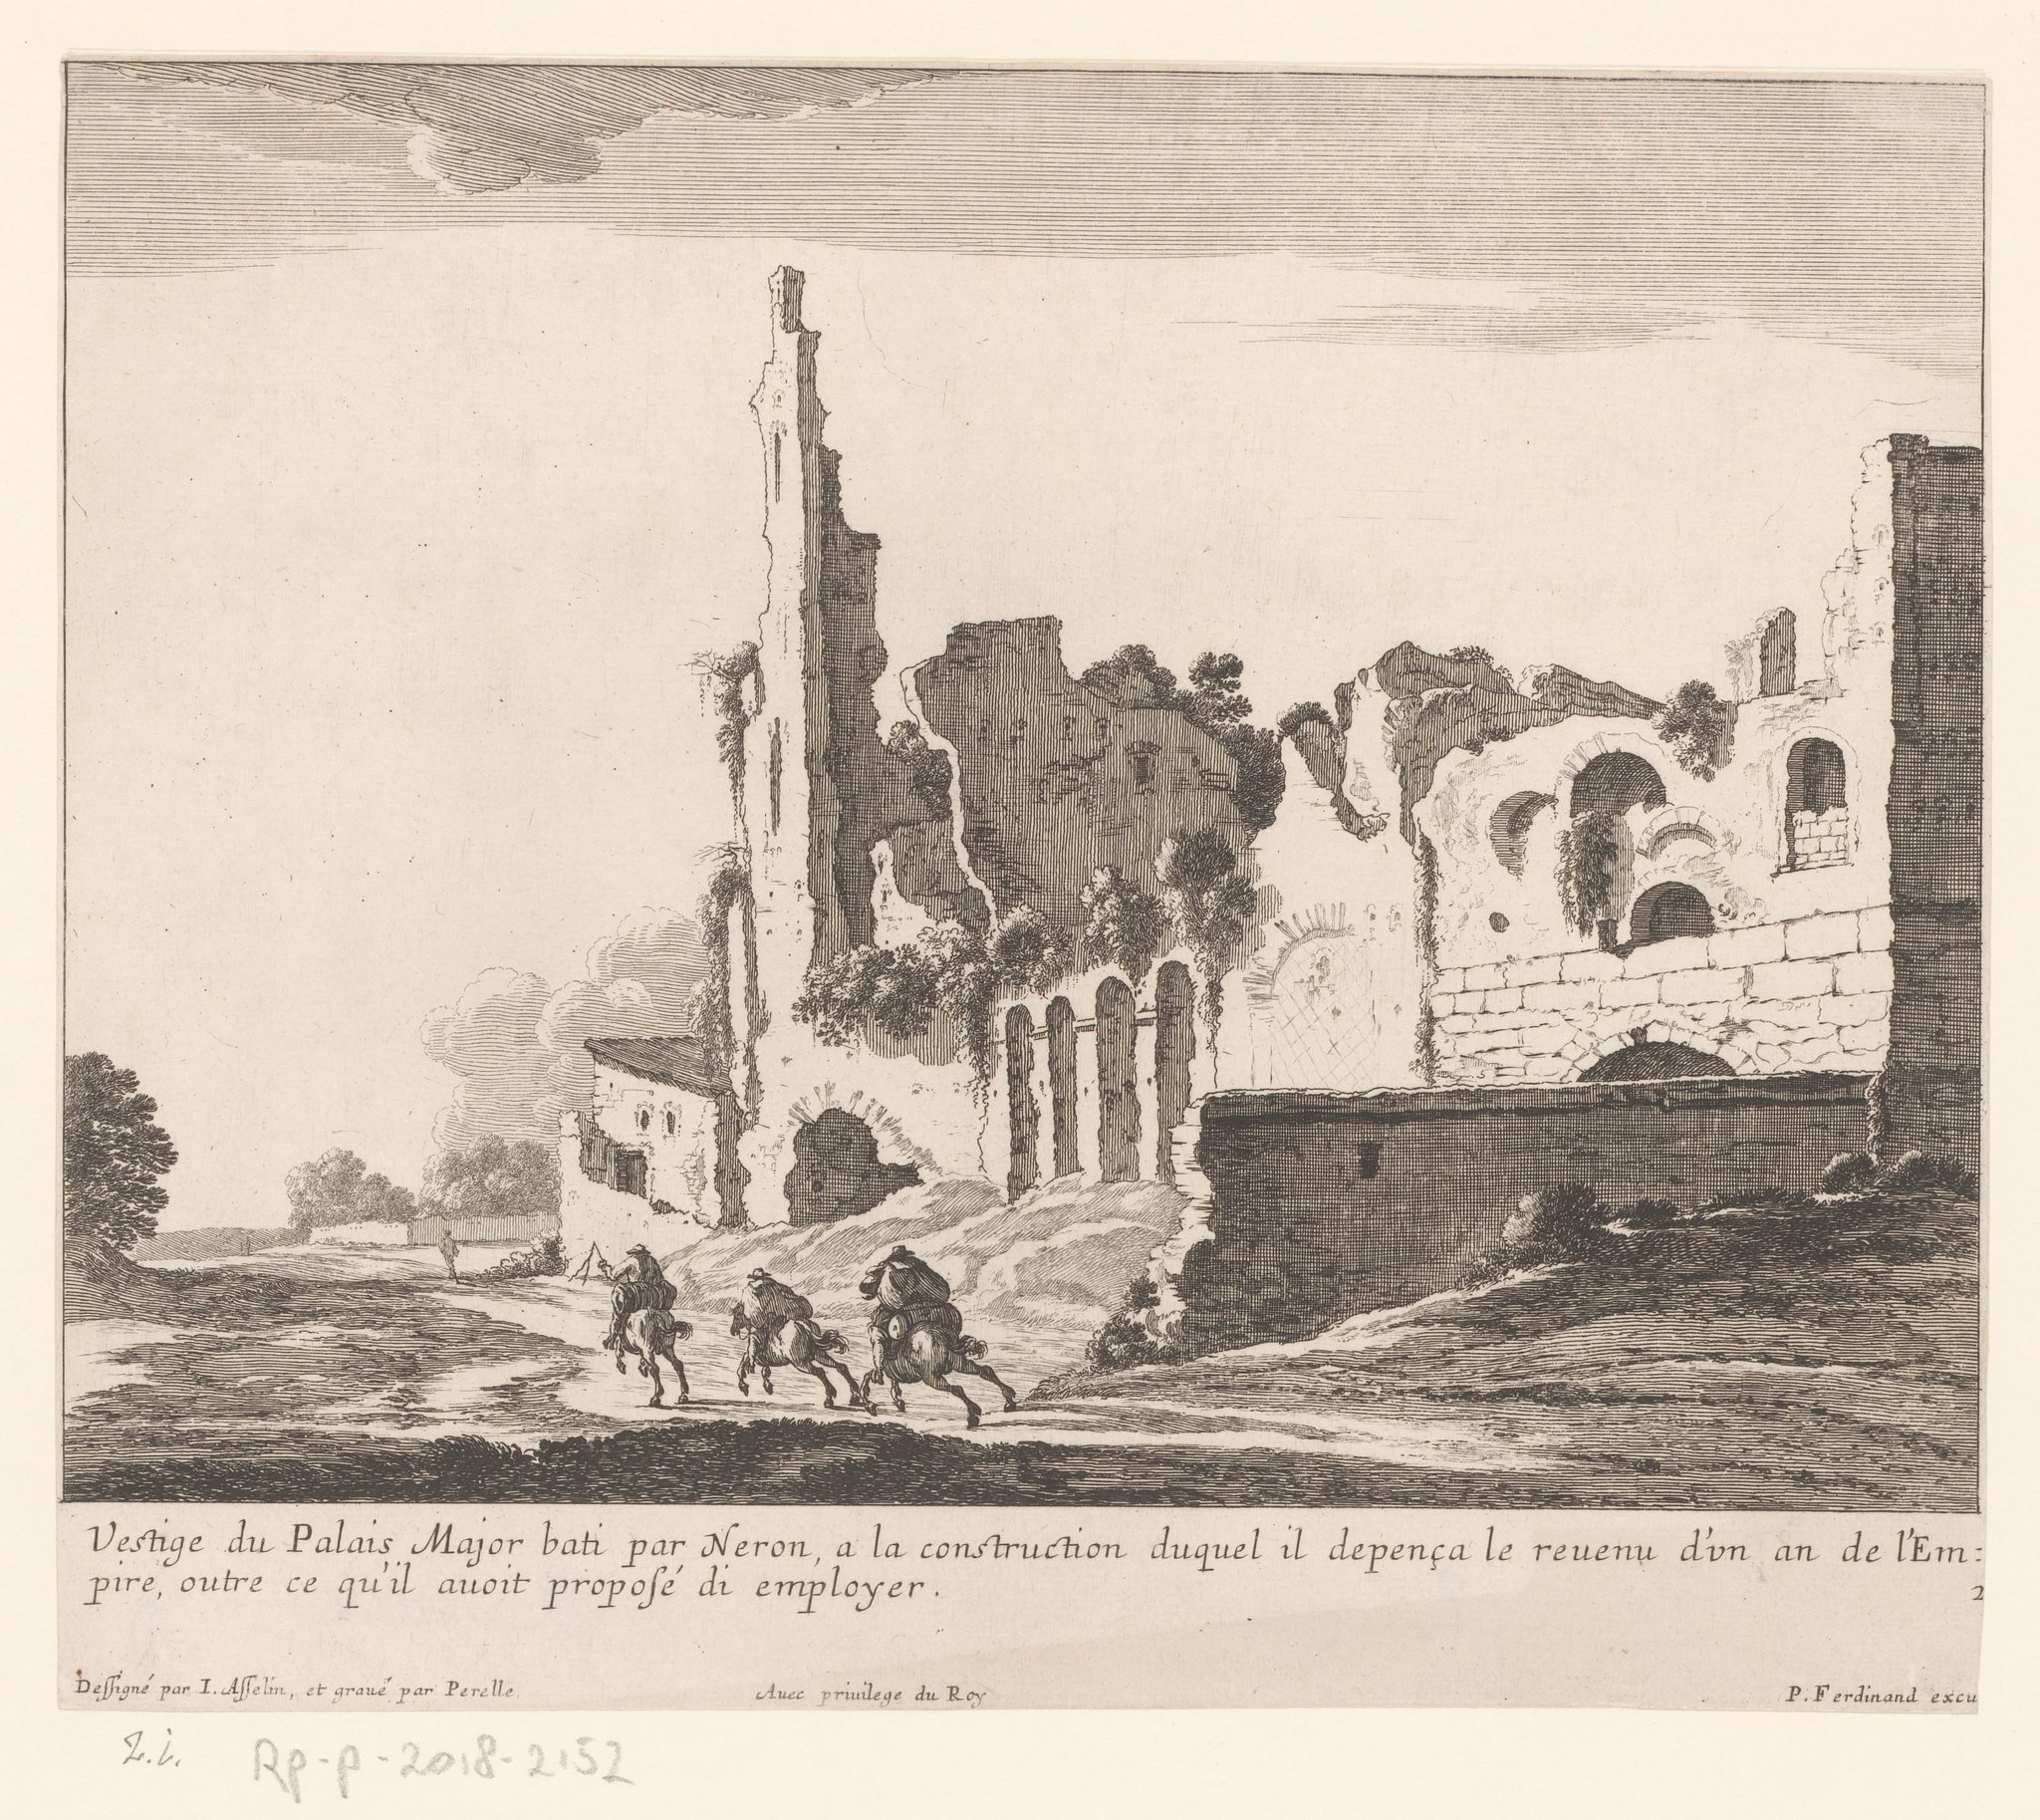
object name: print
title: Gezicht op de ruïnes van de Domus Aurea, te Rome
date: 1641-1655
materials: paper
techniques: engraving, etching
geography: paris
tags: landscape with ruins, ruin of a dwelling, house, castle, etc.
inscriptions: collector's mark: Lugt 240